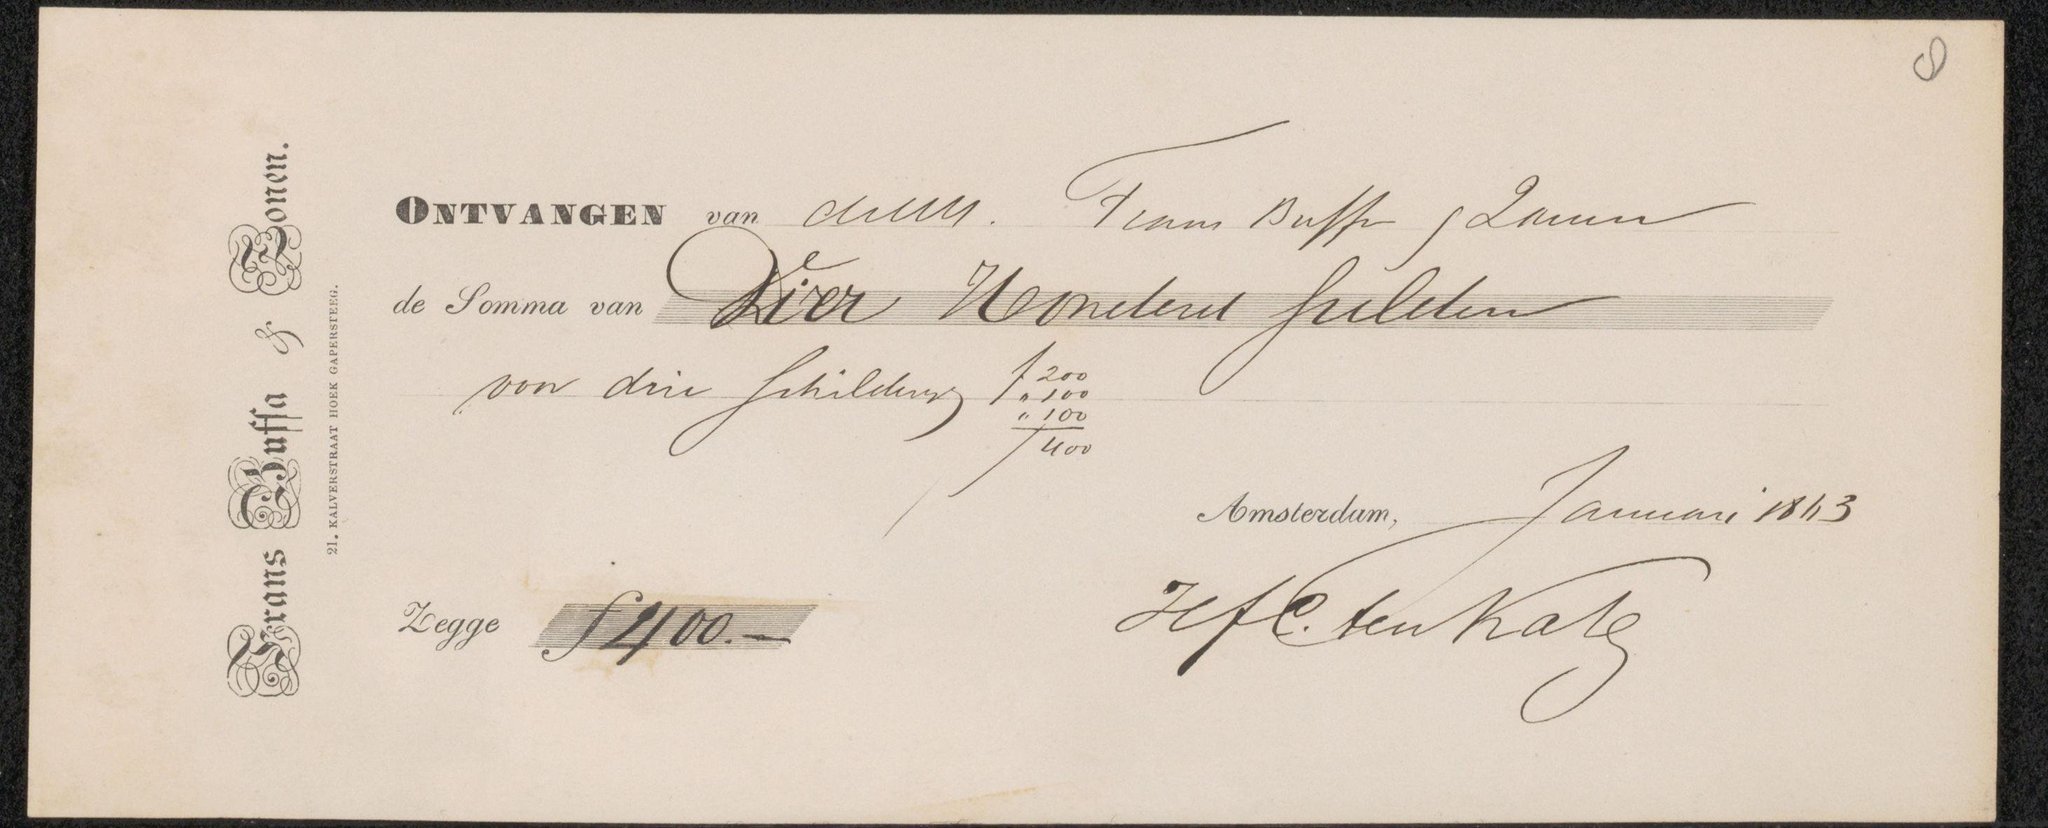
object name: ontvangstbewijs, kwitantie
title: Kwitantie voor Herman Frederik Carel ten Kate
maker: herman frederik carel ten kate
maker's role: draughtsman, painter, print maker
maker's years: 1822-1891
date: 1801-1843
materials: ink, paper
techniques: pen, printing, writing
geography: amsterdam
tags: painting (including book-illumination, miniature-painting), money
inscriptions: collector's mark: Lugt 2233